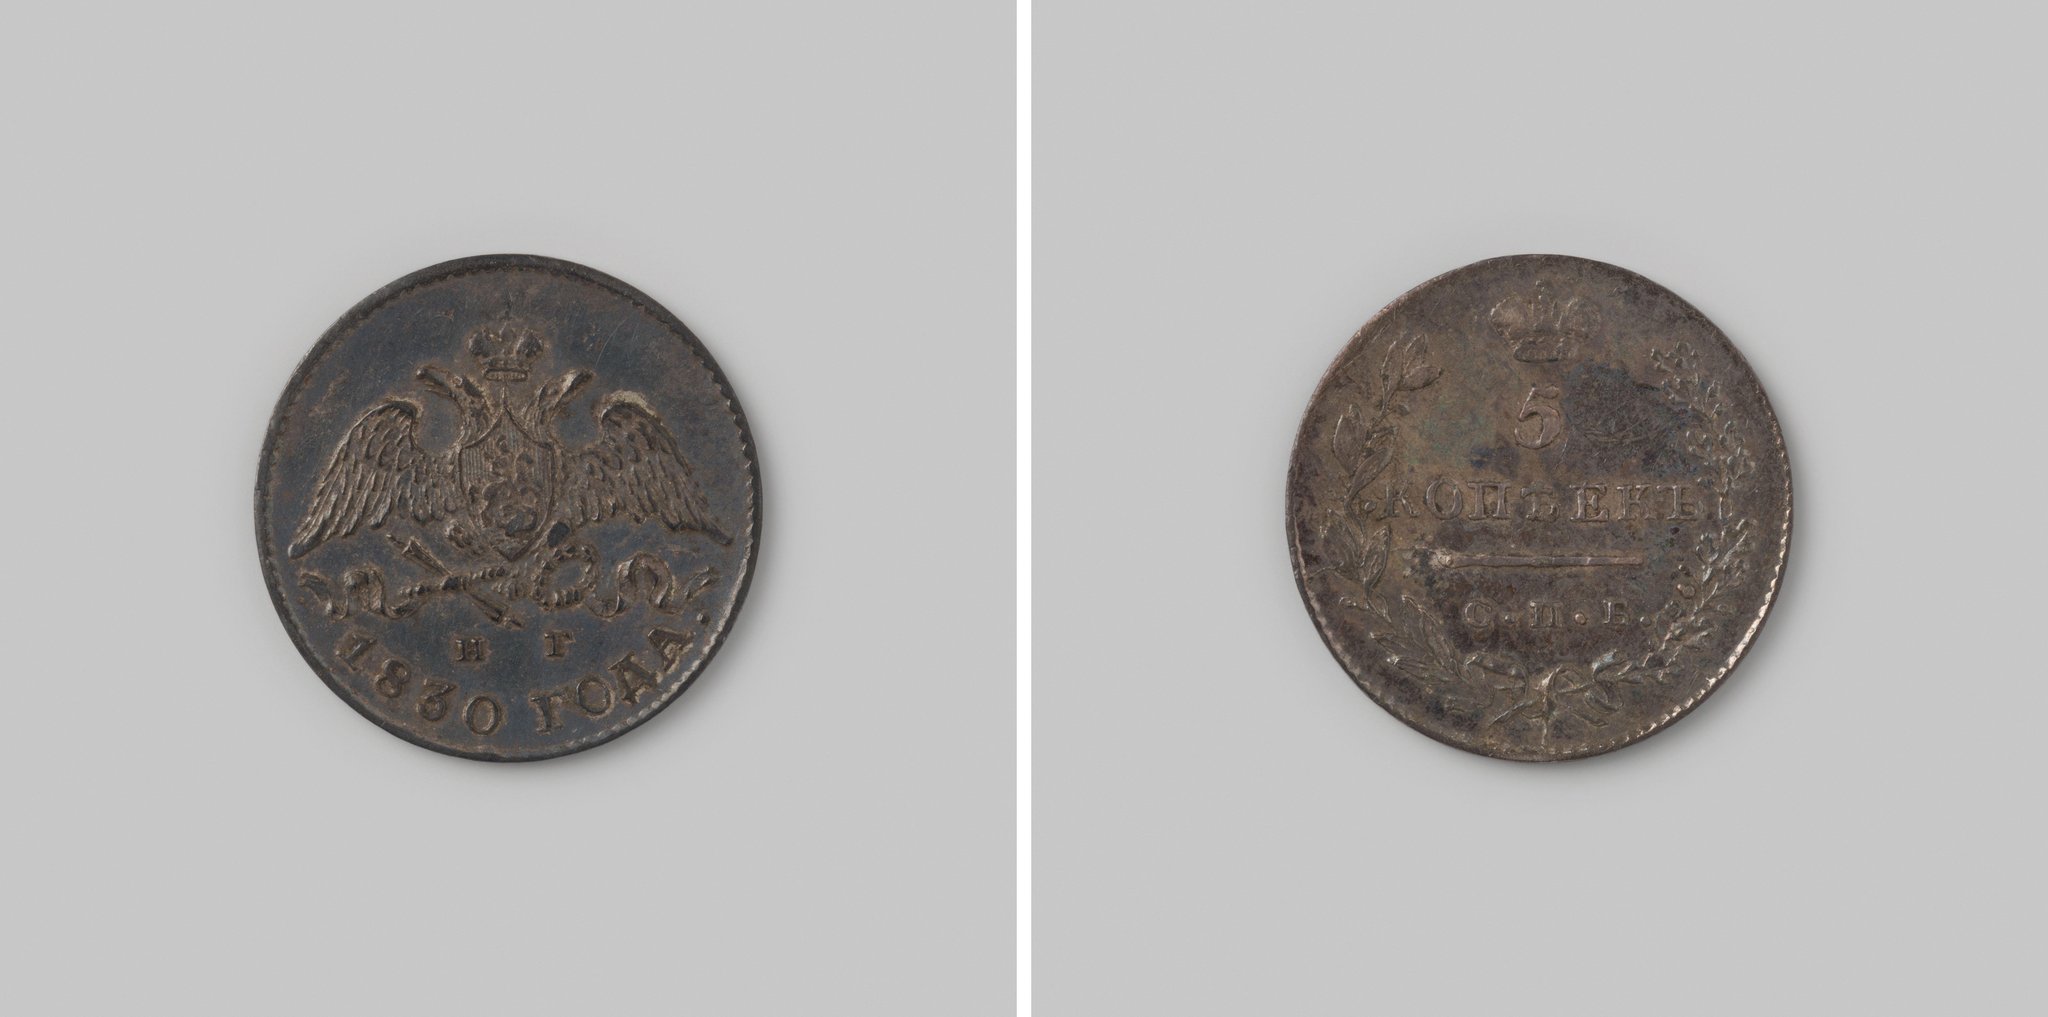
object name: coin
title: 5 kopeken uit Rusland van tsaar Nikolai I, 1830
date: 1830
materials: silver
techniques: striking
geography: sint-petersburg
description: Zilveren munt. Voorzijde: dubbelkoppige gekroonde adelaar met gespreide vleugels en met op zijn bosrt een wapenschild en op zijn staart verschillende attributen. Boven de adelaar een kroon. Onderaan links jaartal. Keerzijde: tussen twee samengebonden takken een kroon, waaaronder in twee regels de waarde-aanduiding. Daaronder jaartal, waaronder in het Cyrillisch de letters S,P en B [=Sint Petersburg]. Kabelrand.